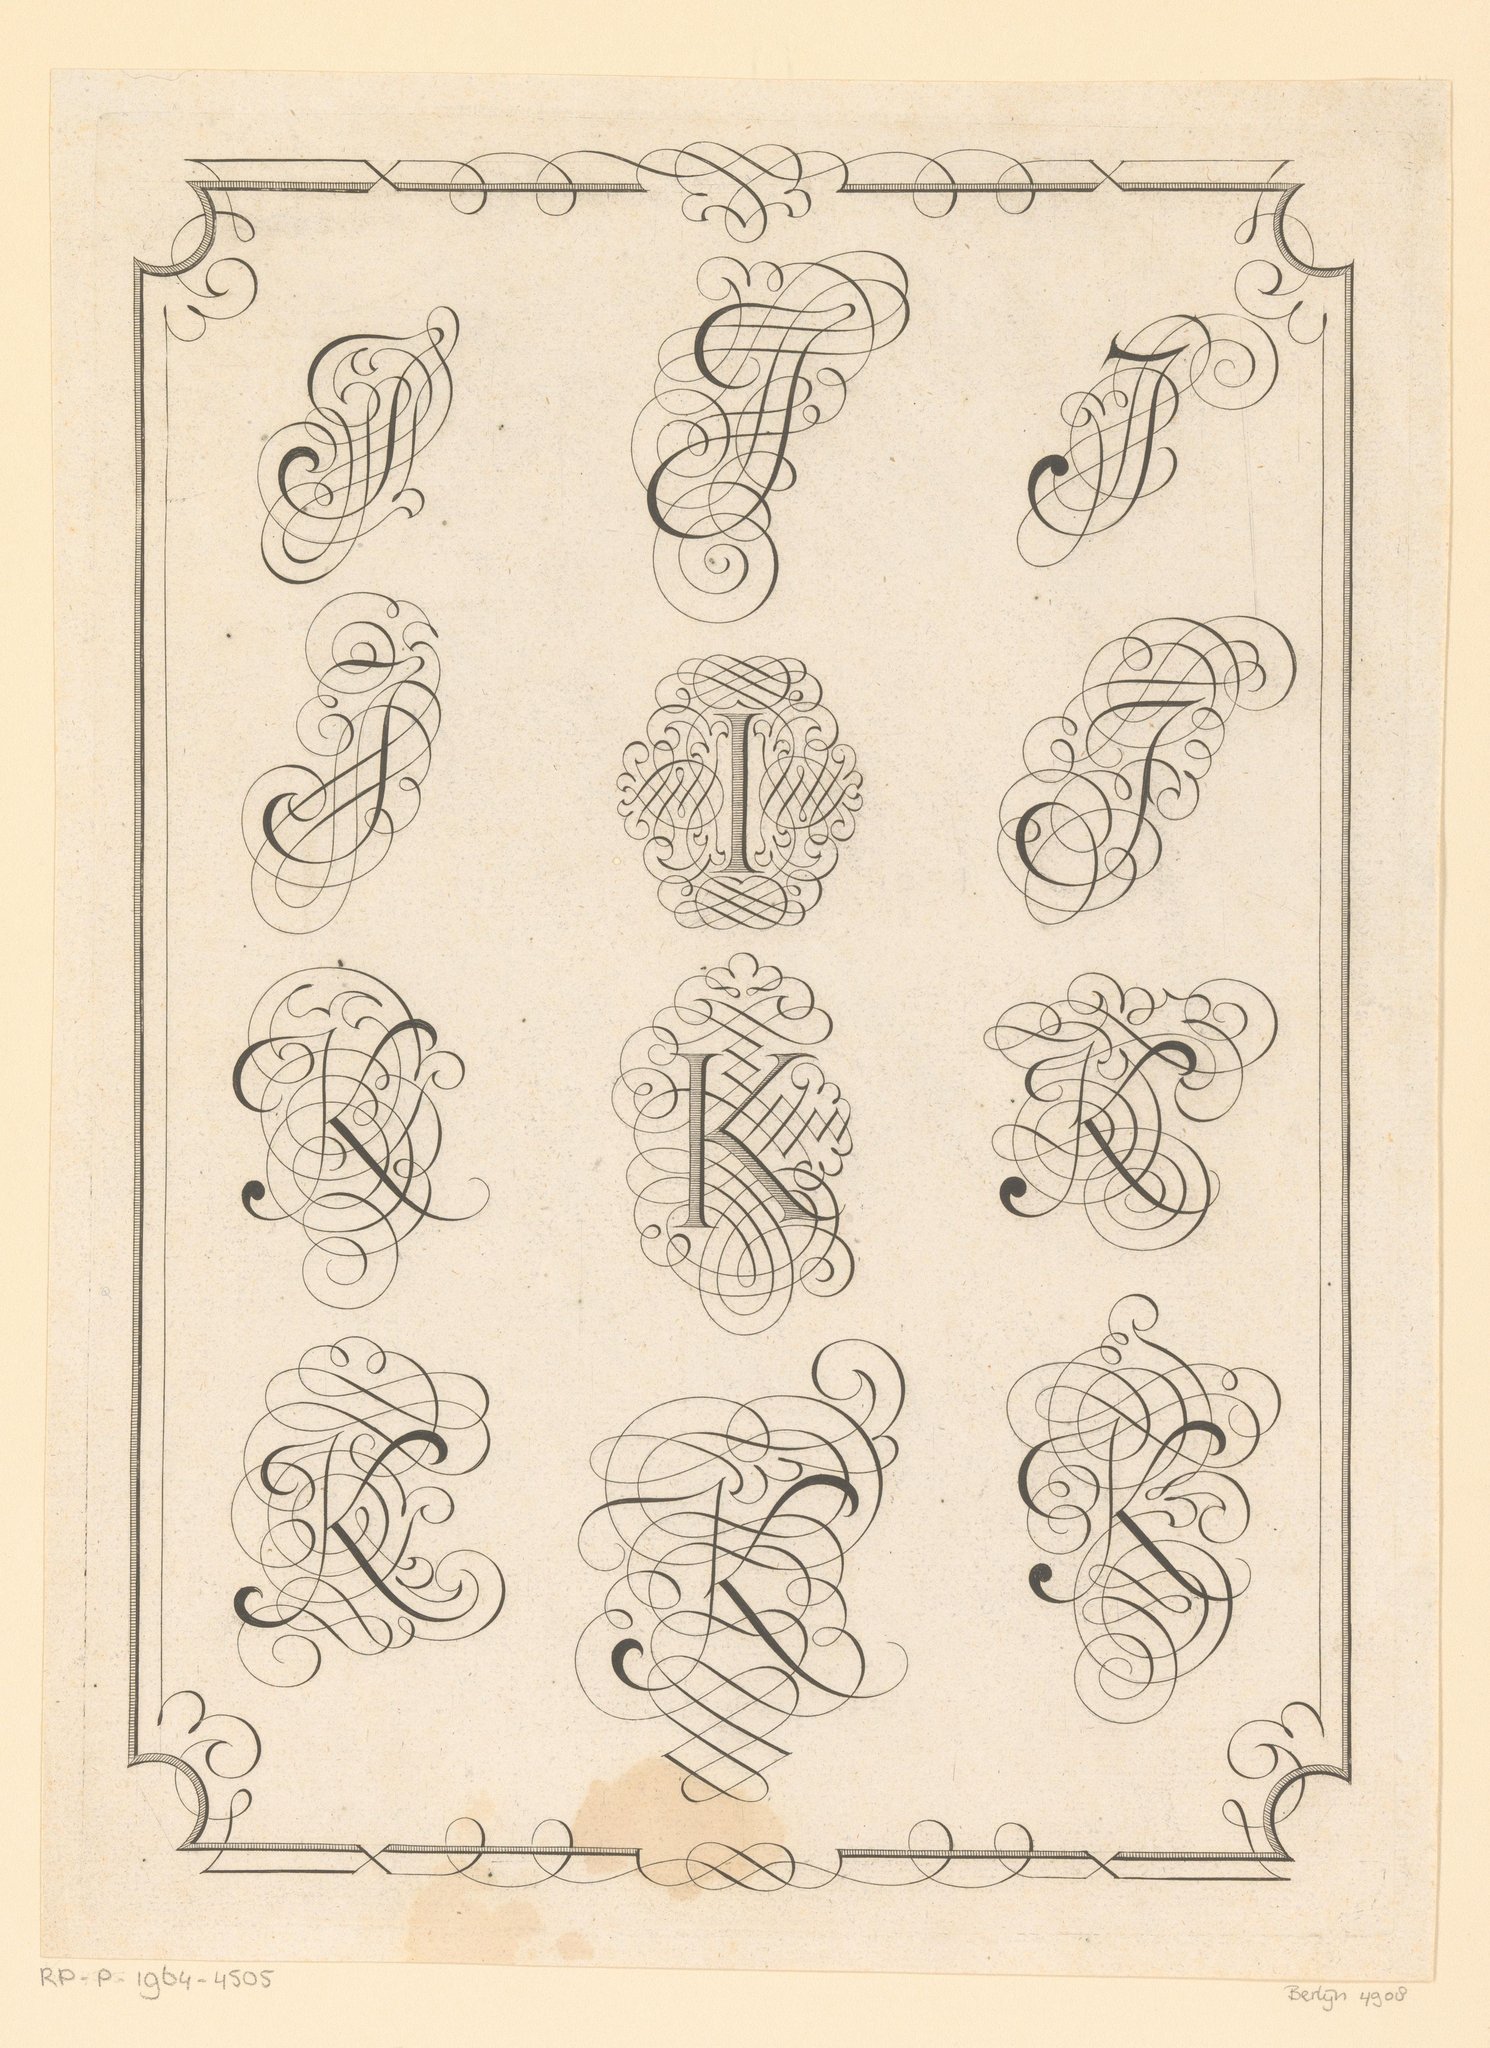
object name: print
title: Letters I en K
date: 1756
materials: paper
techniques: engraving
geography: vienna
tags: letters, alphabet, script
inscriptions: collector's mark: Lugt 2228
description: Zesmaal gekalligrafeerde letters I en K.